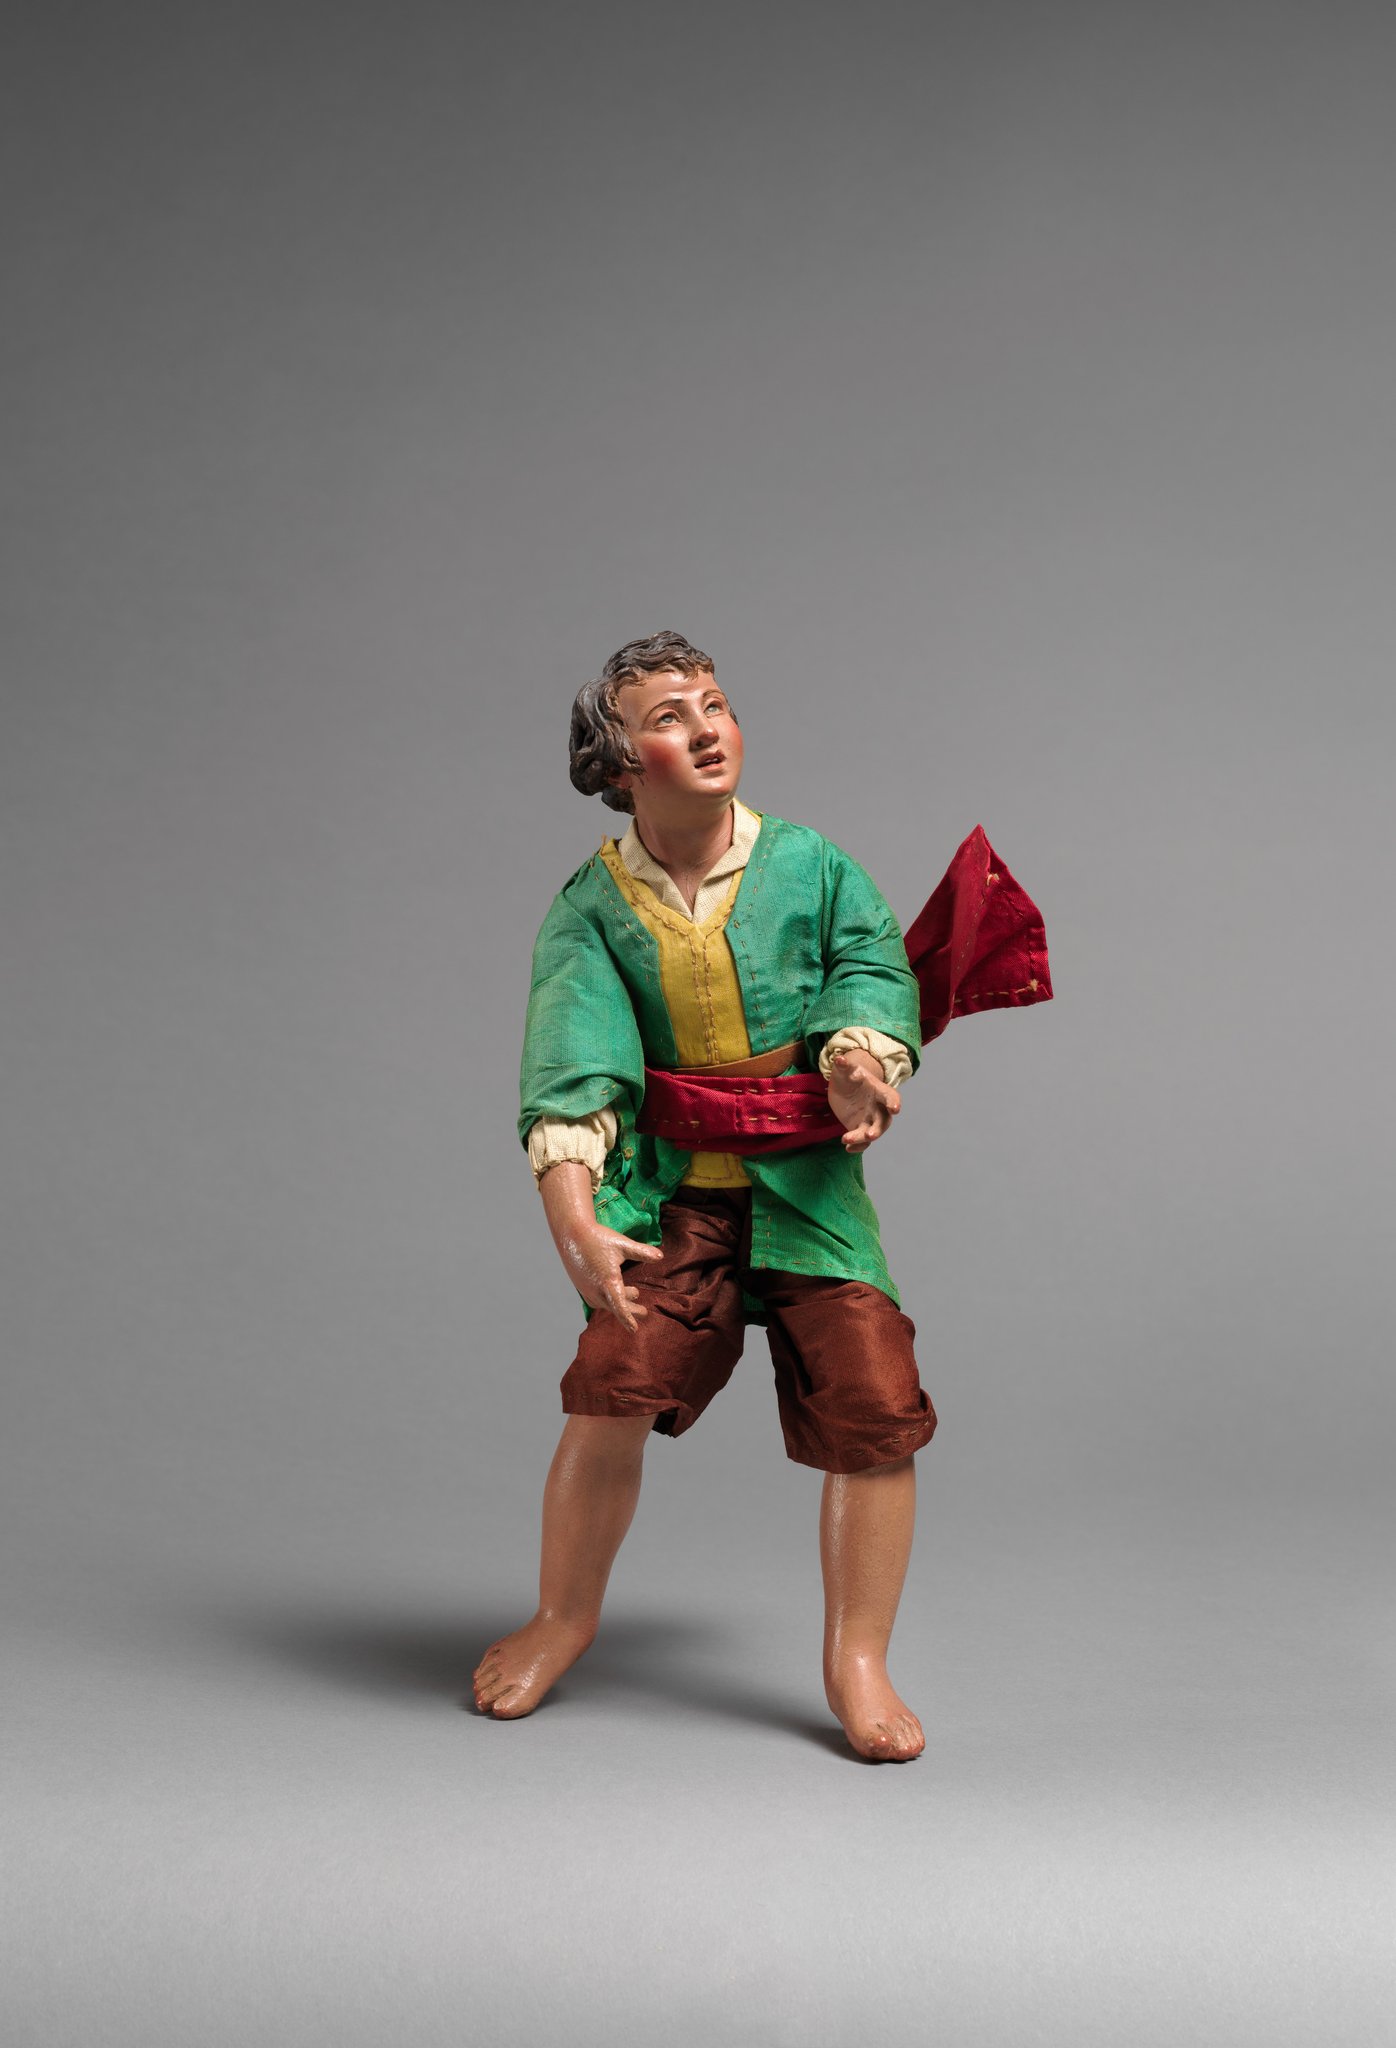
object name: crèche figure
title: Boy in green shirt, brown pants, red sash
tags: boys